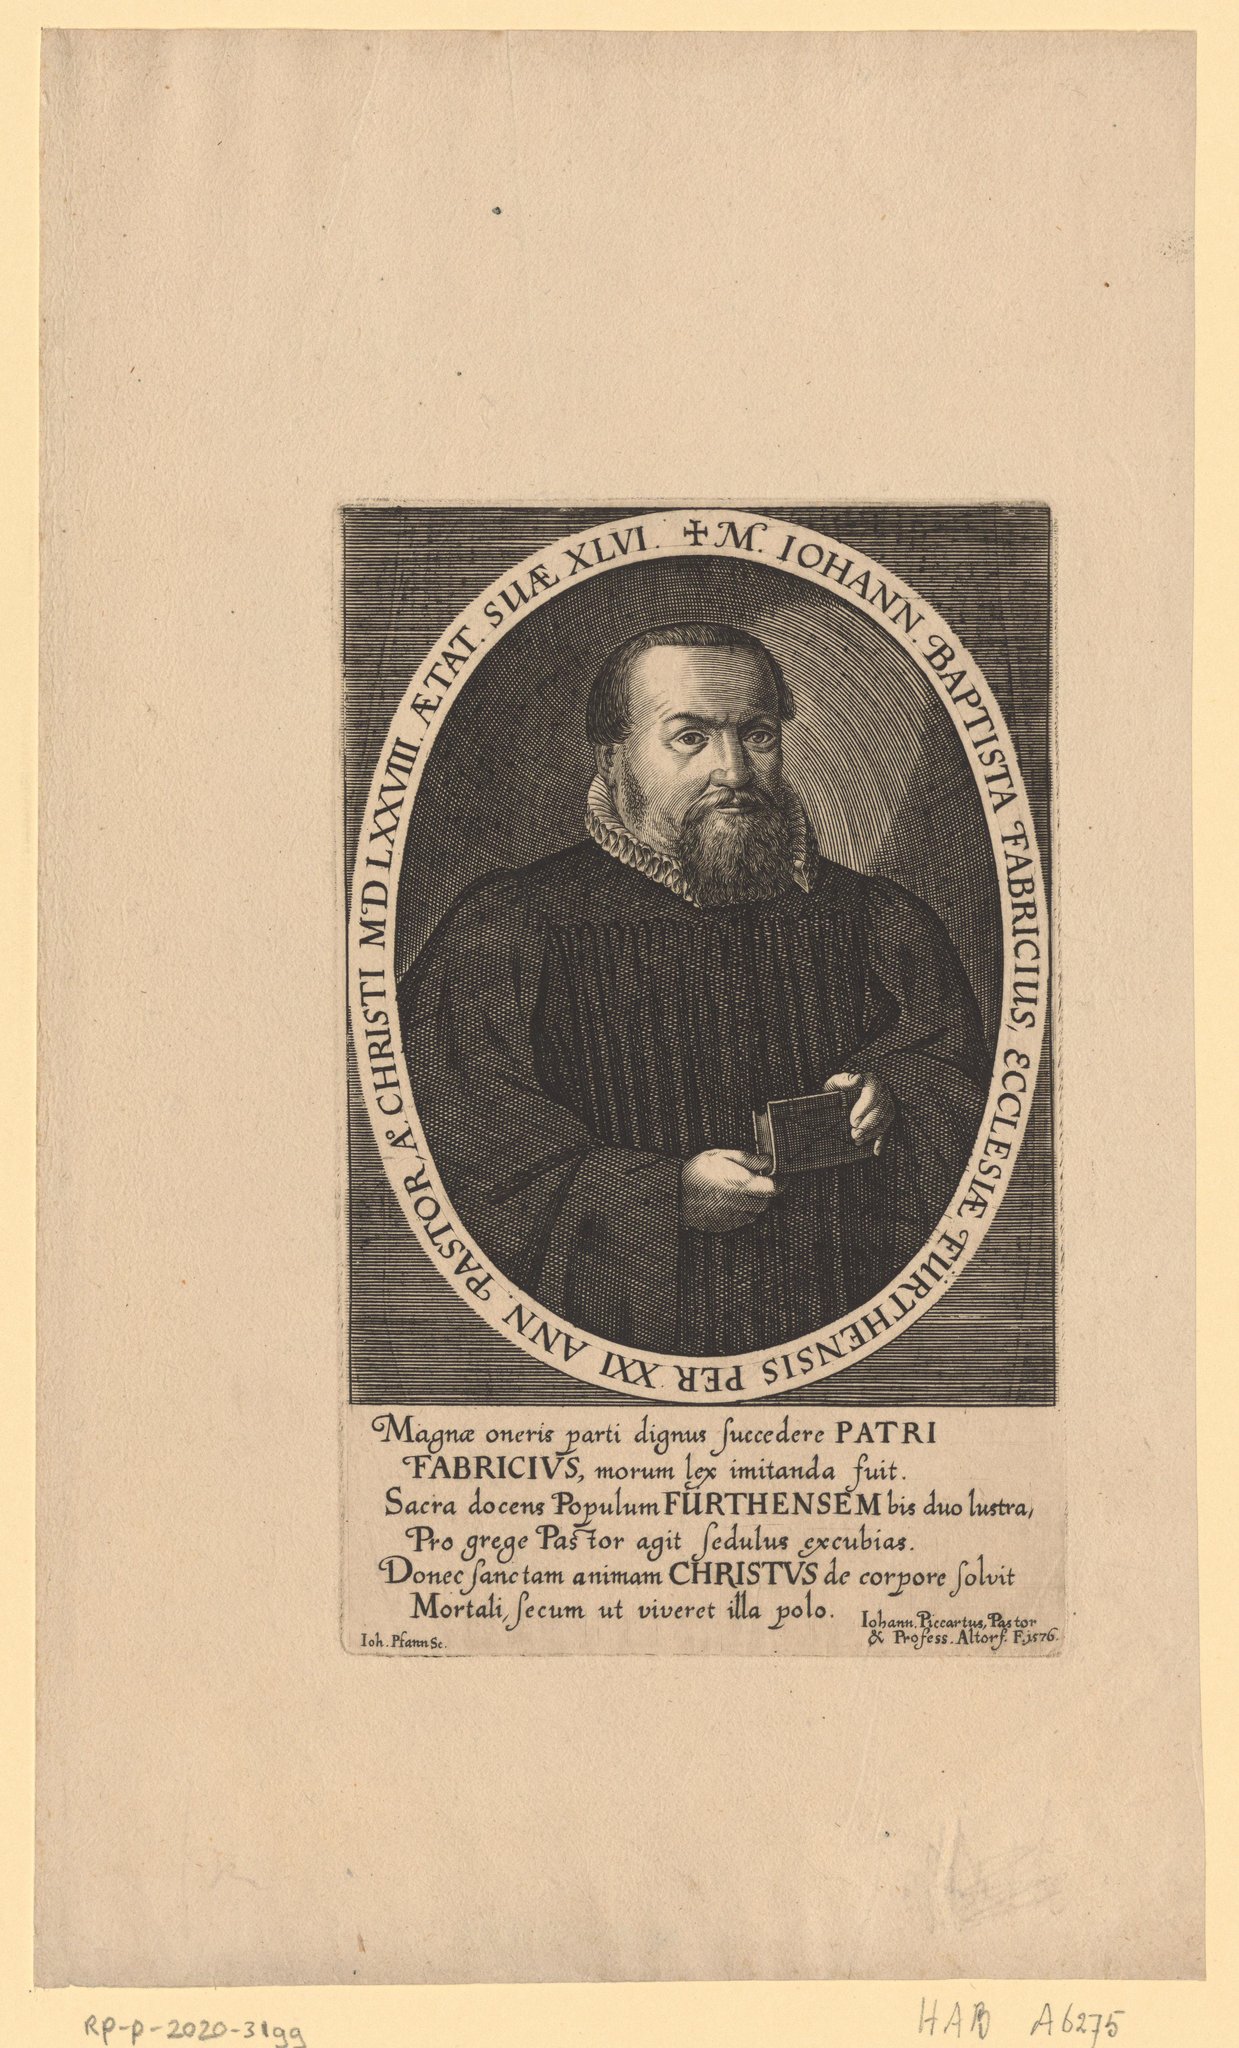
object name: print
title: Portret van Johann Baptist Fabricius op 46-jarige leeftijd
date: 1648-1663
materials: paper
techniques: engraving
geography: germany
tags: theologian, historical persons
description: Met zesregelig vers in het Latijn onder het portret.